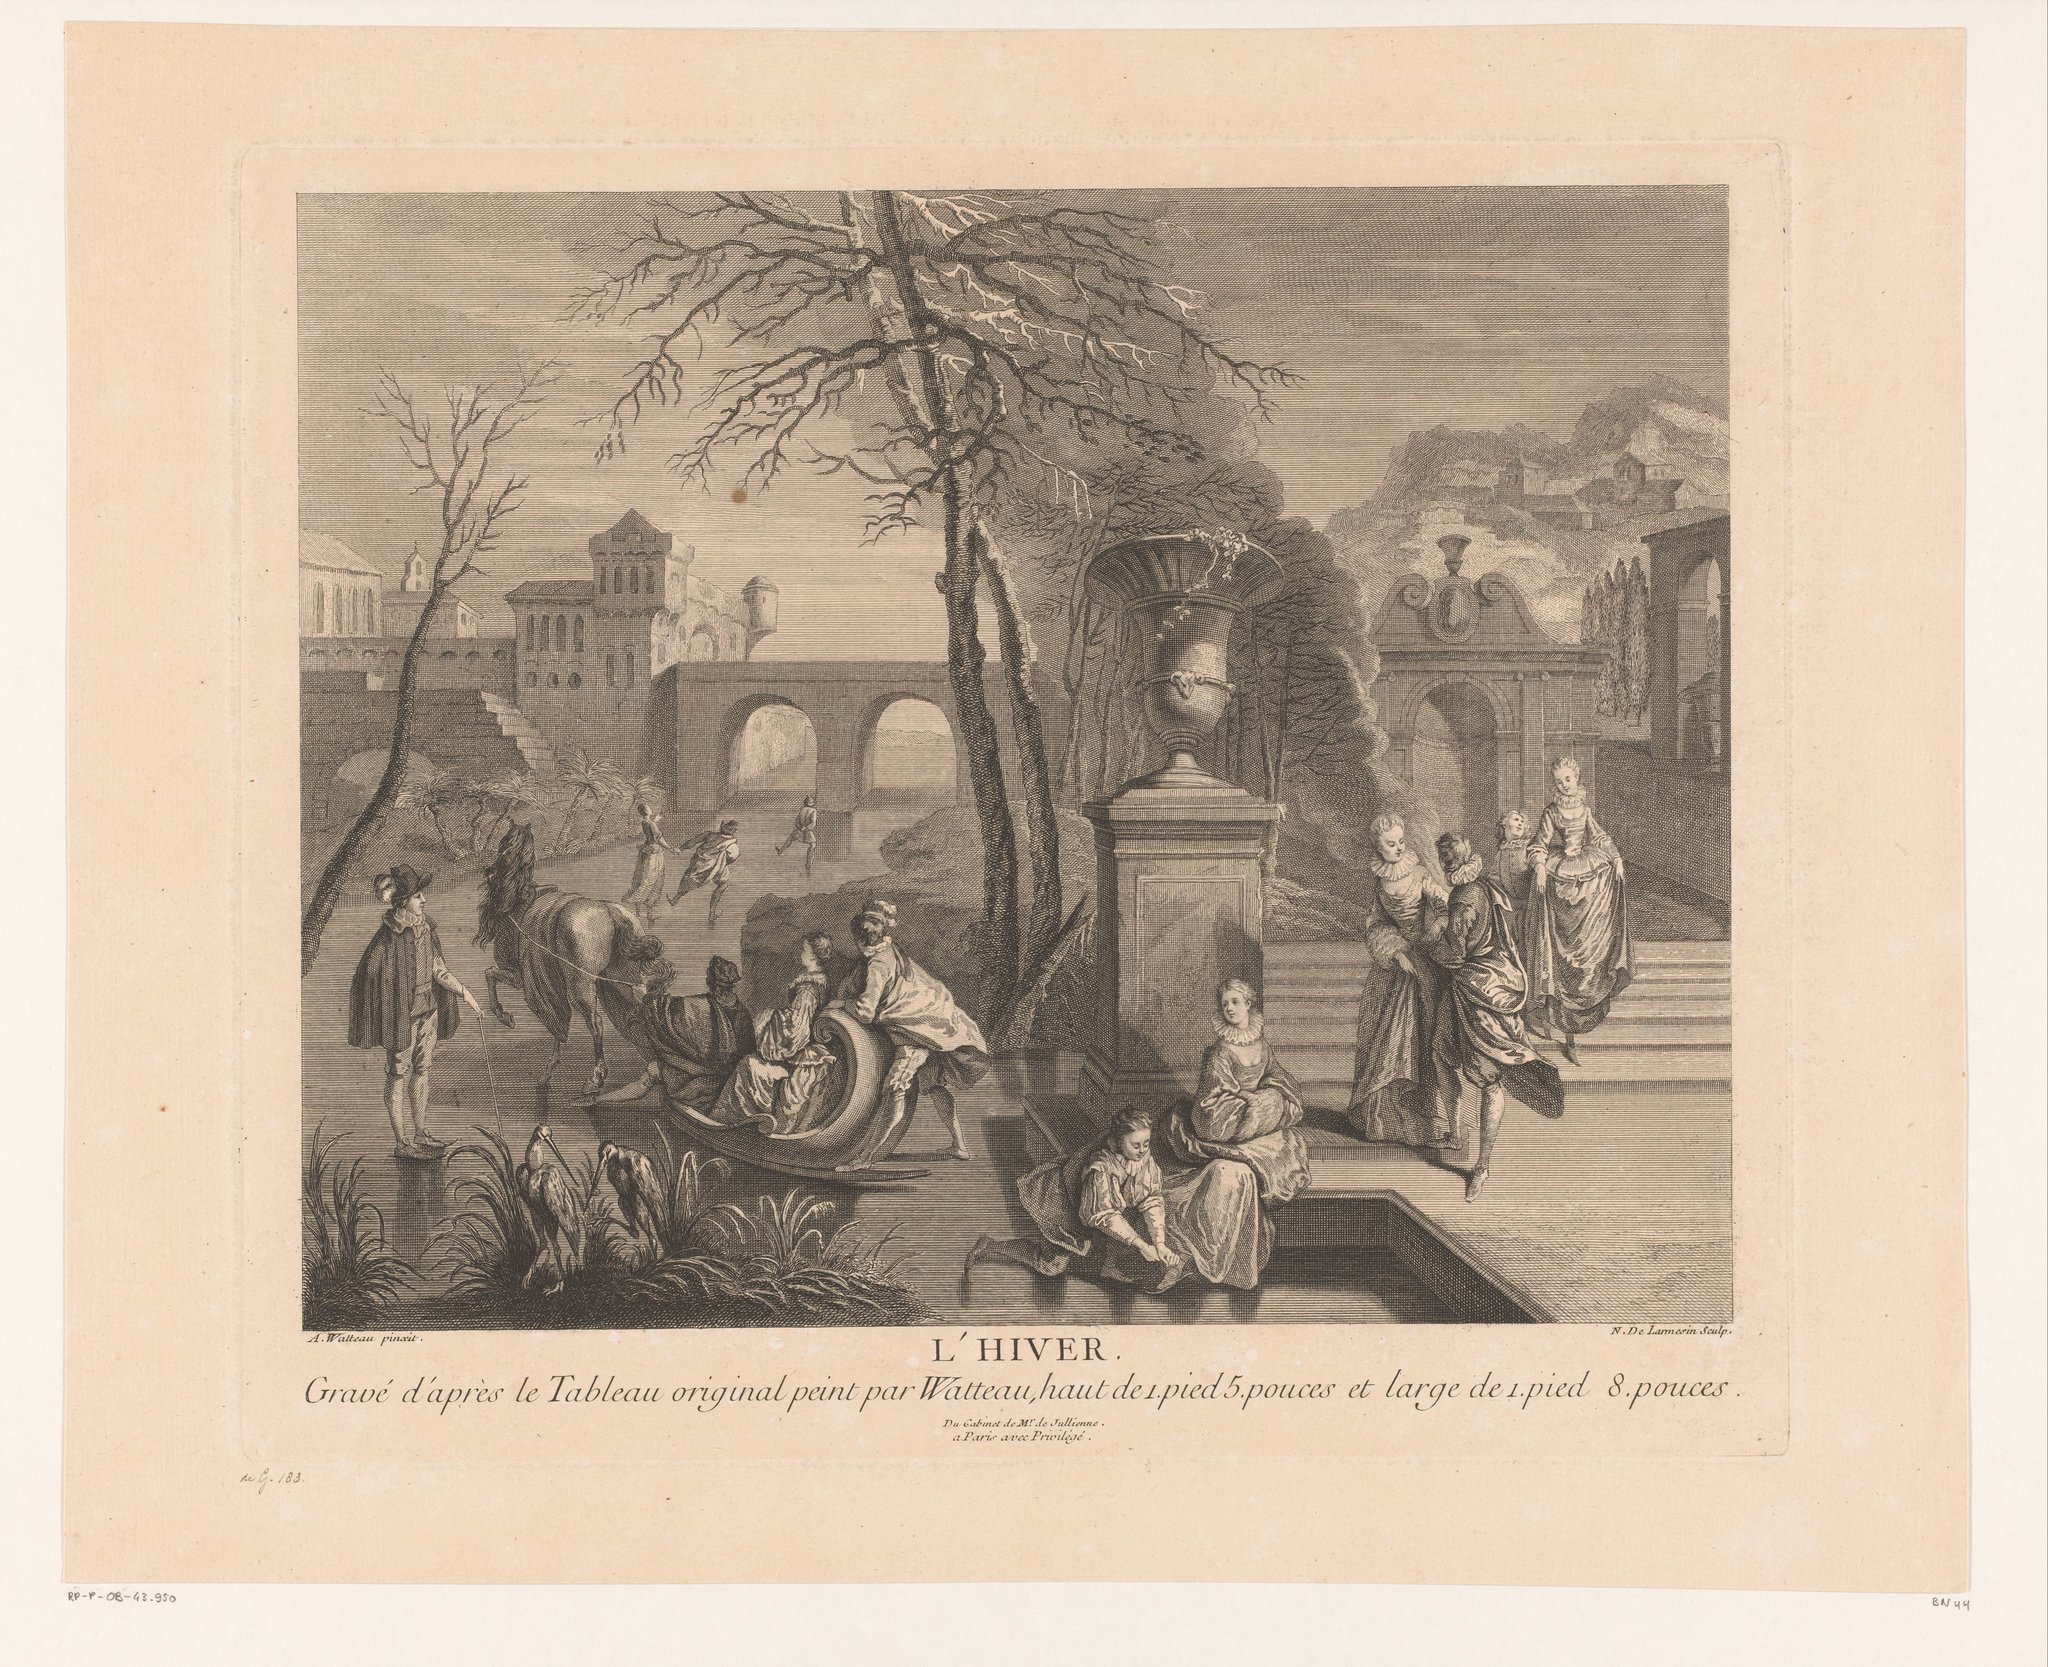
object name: print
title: L'Hyver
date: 1732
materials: paper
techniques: engraving, etching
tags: winter ~ human activities (the four seasons of the year), skates (winter sports)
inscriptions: collector's mark: Lugt 2228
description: Maakt deel uit van een serie van 271 platen, inclusief twee titelprenten, naar schilderijen door Watteau en verzameld door Jean de Jullienne. Sommige platen werden reeds tijdens Watteau's leven vervaardigd en de rest kwam pas na zijn dood tot stand. In 1734 werd het eind van de serie aangekondigd. Dit betreft plaat 205 uit de serie. De prent maakt eveneens deel uit van een vierdelige reeks met de vier seizoenen.